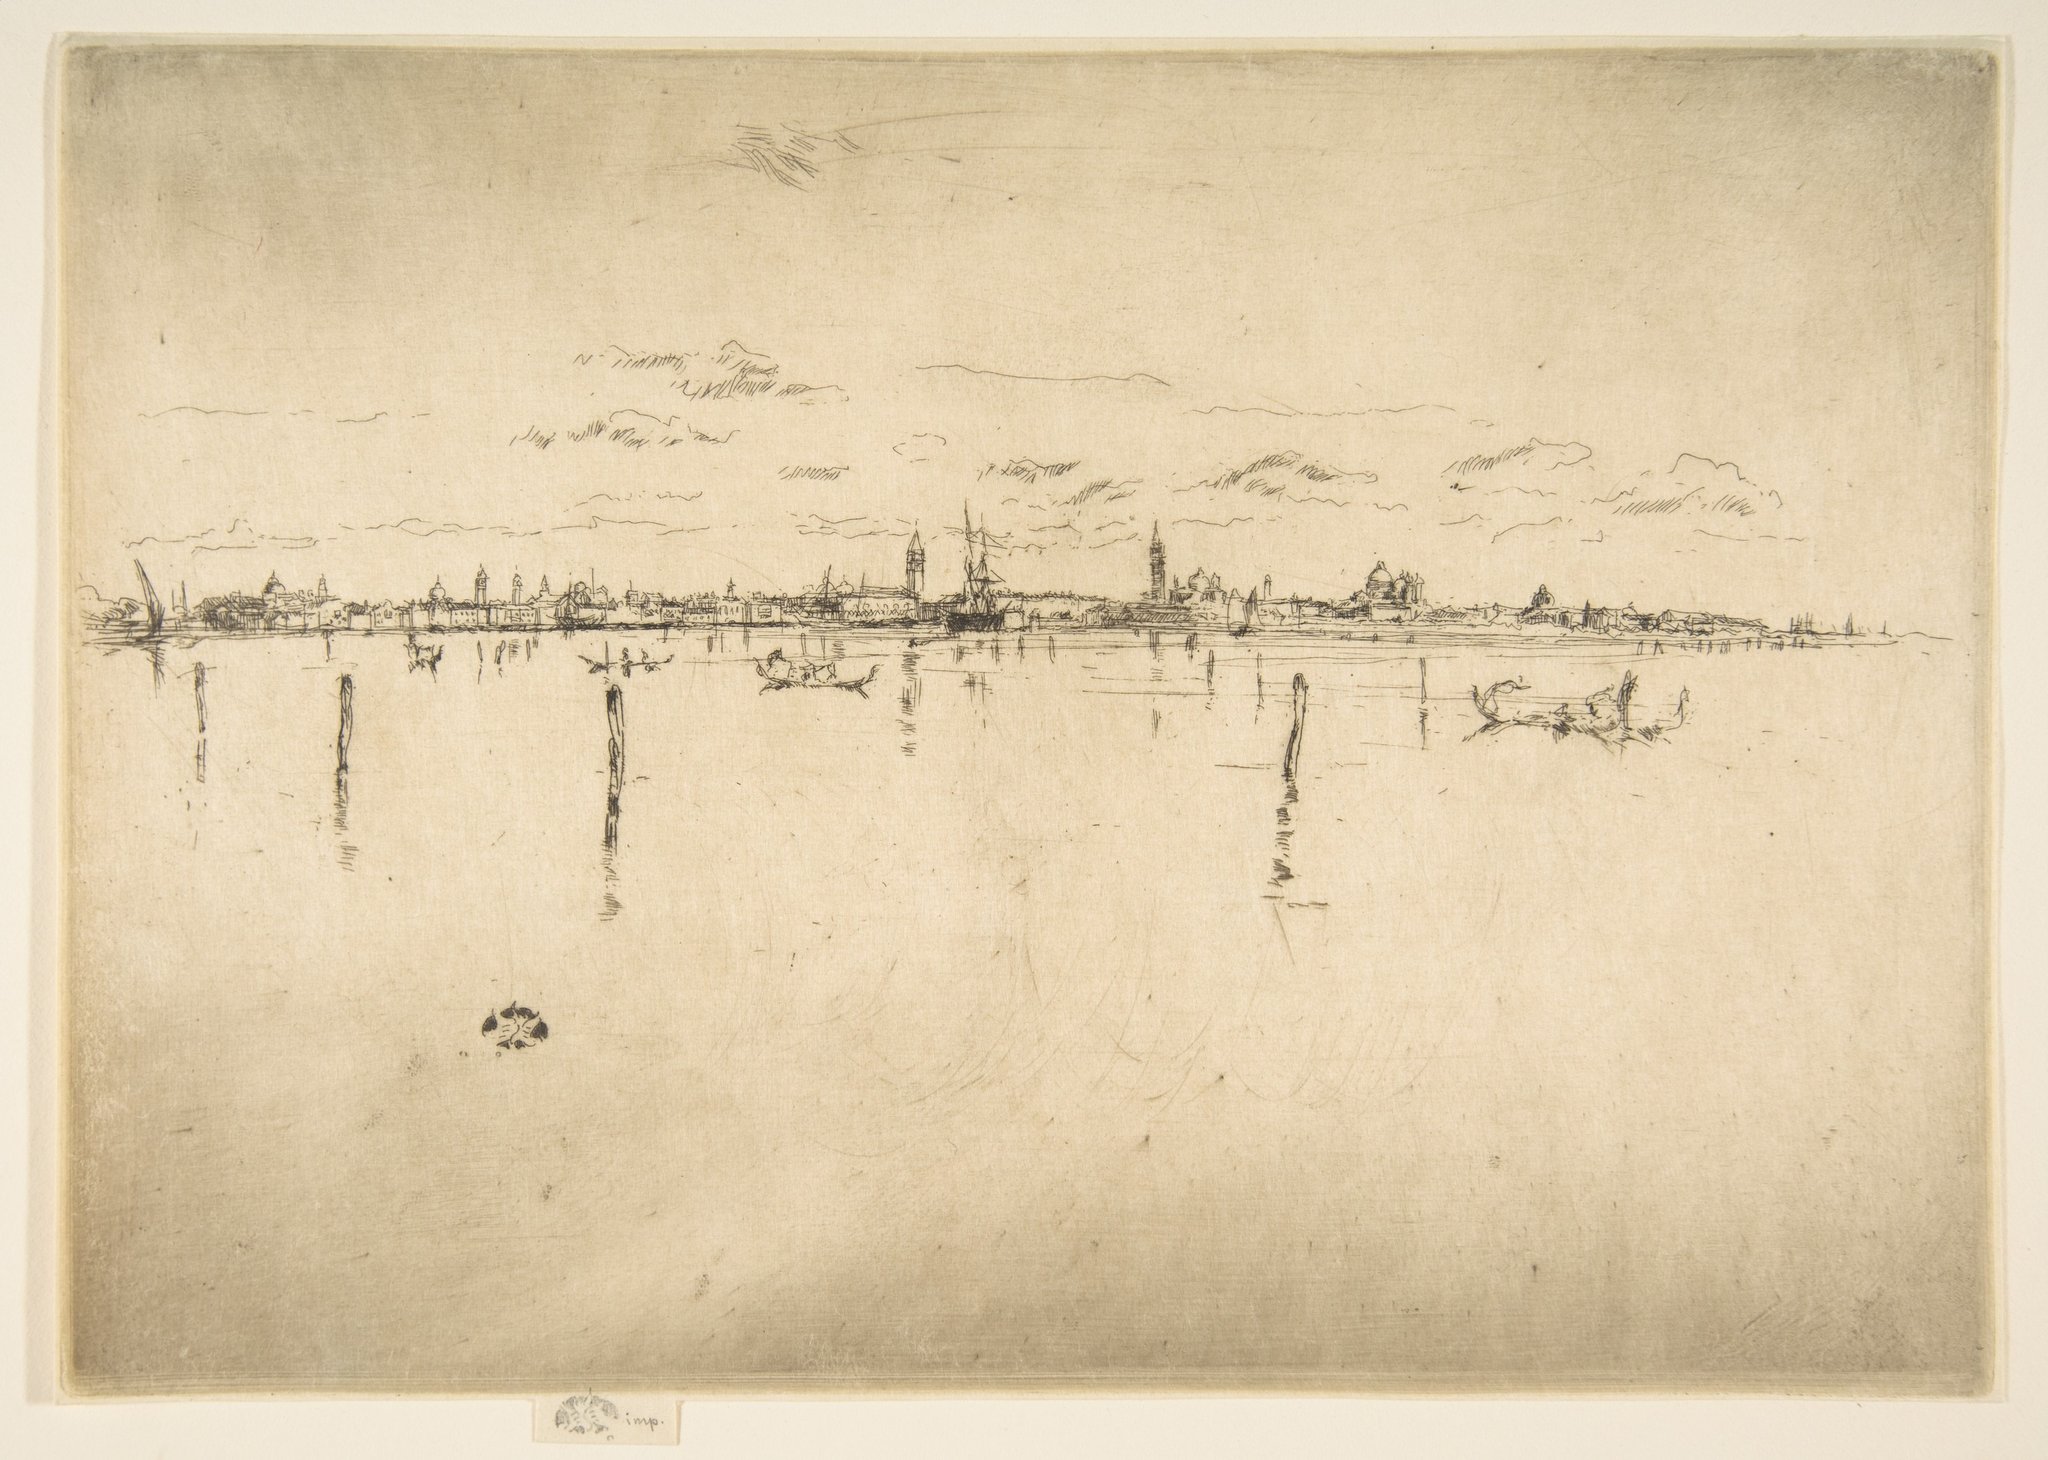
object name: print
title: Little Venice (The Little Venice)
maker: james mcneill whistler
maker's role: artist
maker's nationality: american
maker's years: 1834-1903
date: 1879-1880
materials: ink, paper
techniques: drypoint, etching, printing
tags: boats,venice